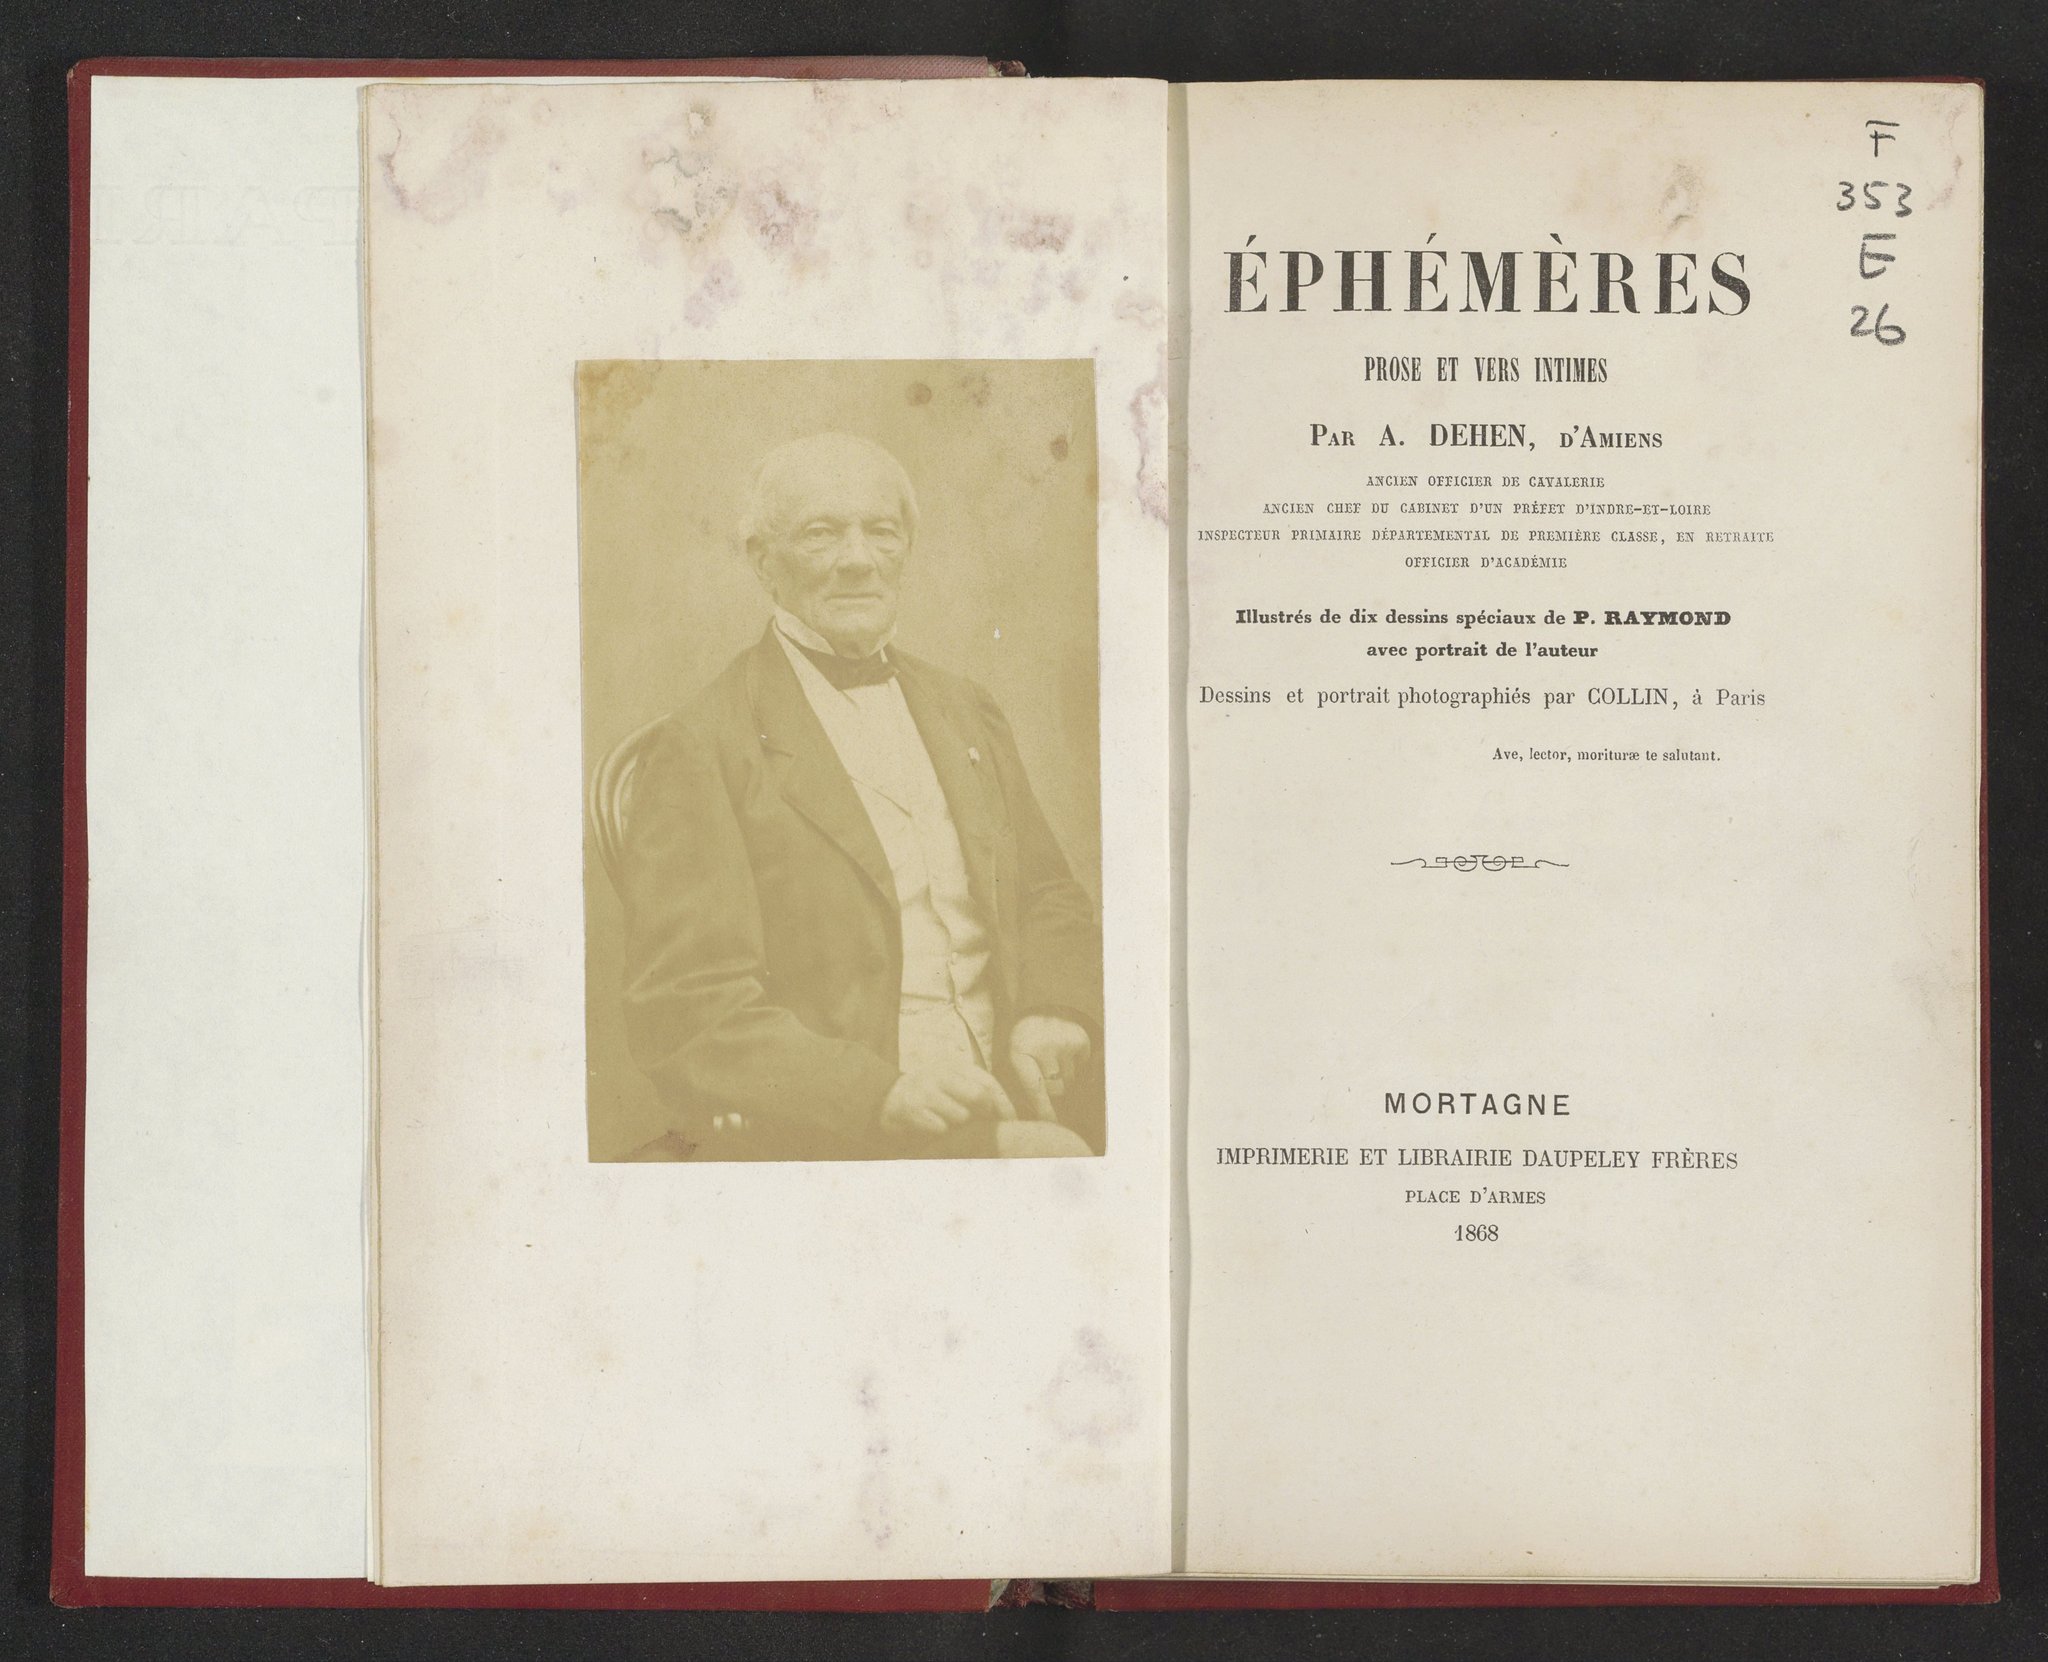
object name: page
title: Portret van vermoedelijk A. Dehen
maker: collin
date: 1858-1868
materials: photographic support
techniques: albumen print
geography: paris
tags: portrait, self-portrait of artist